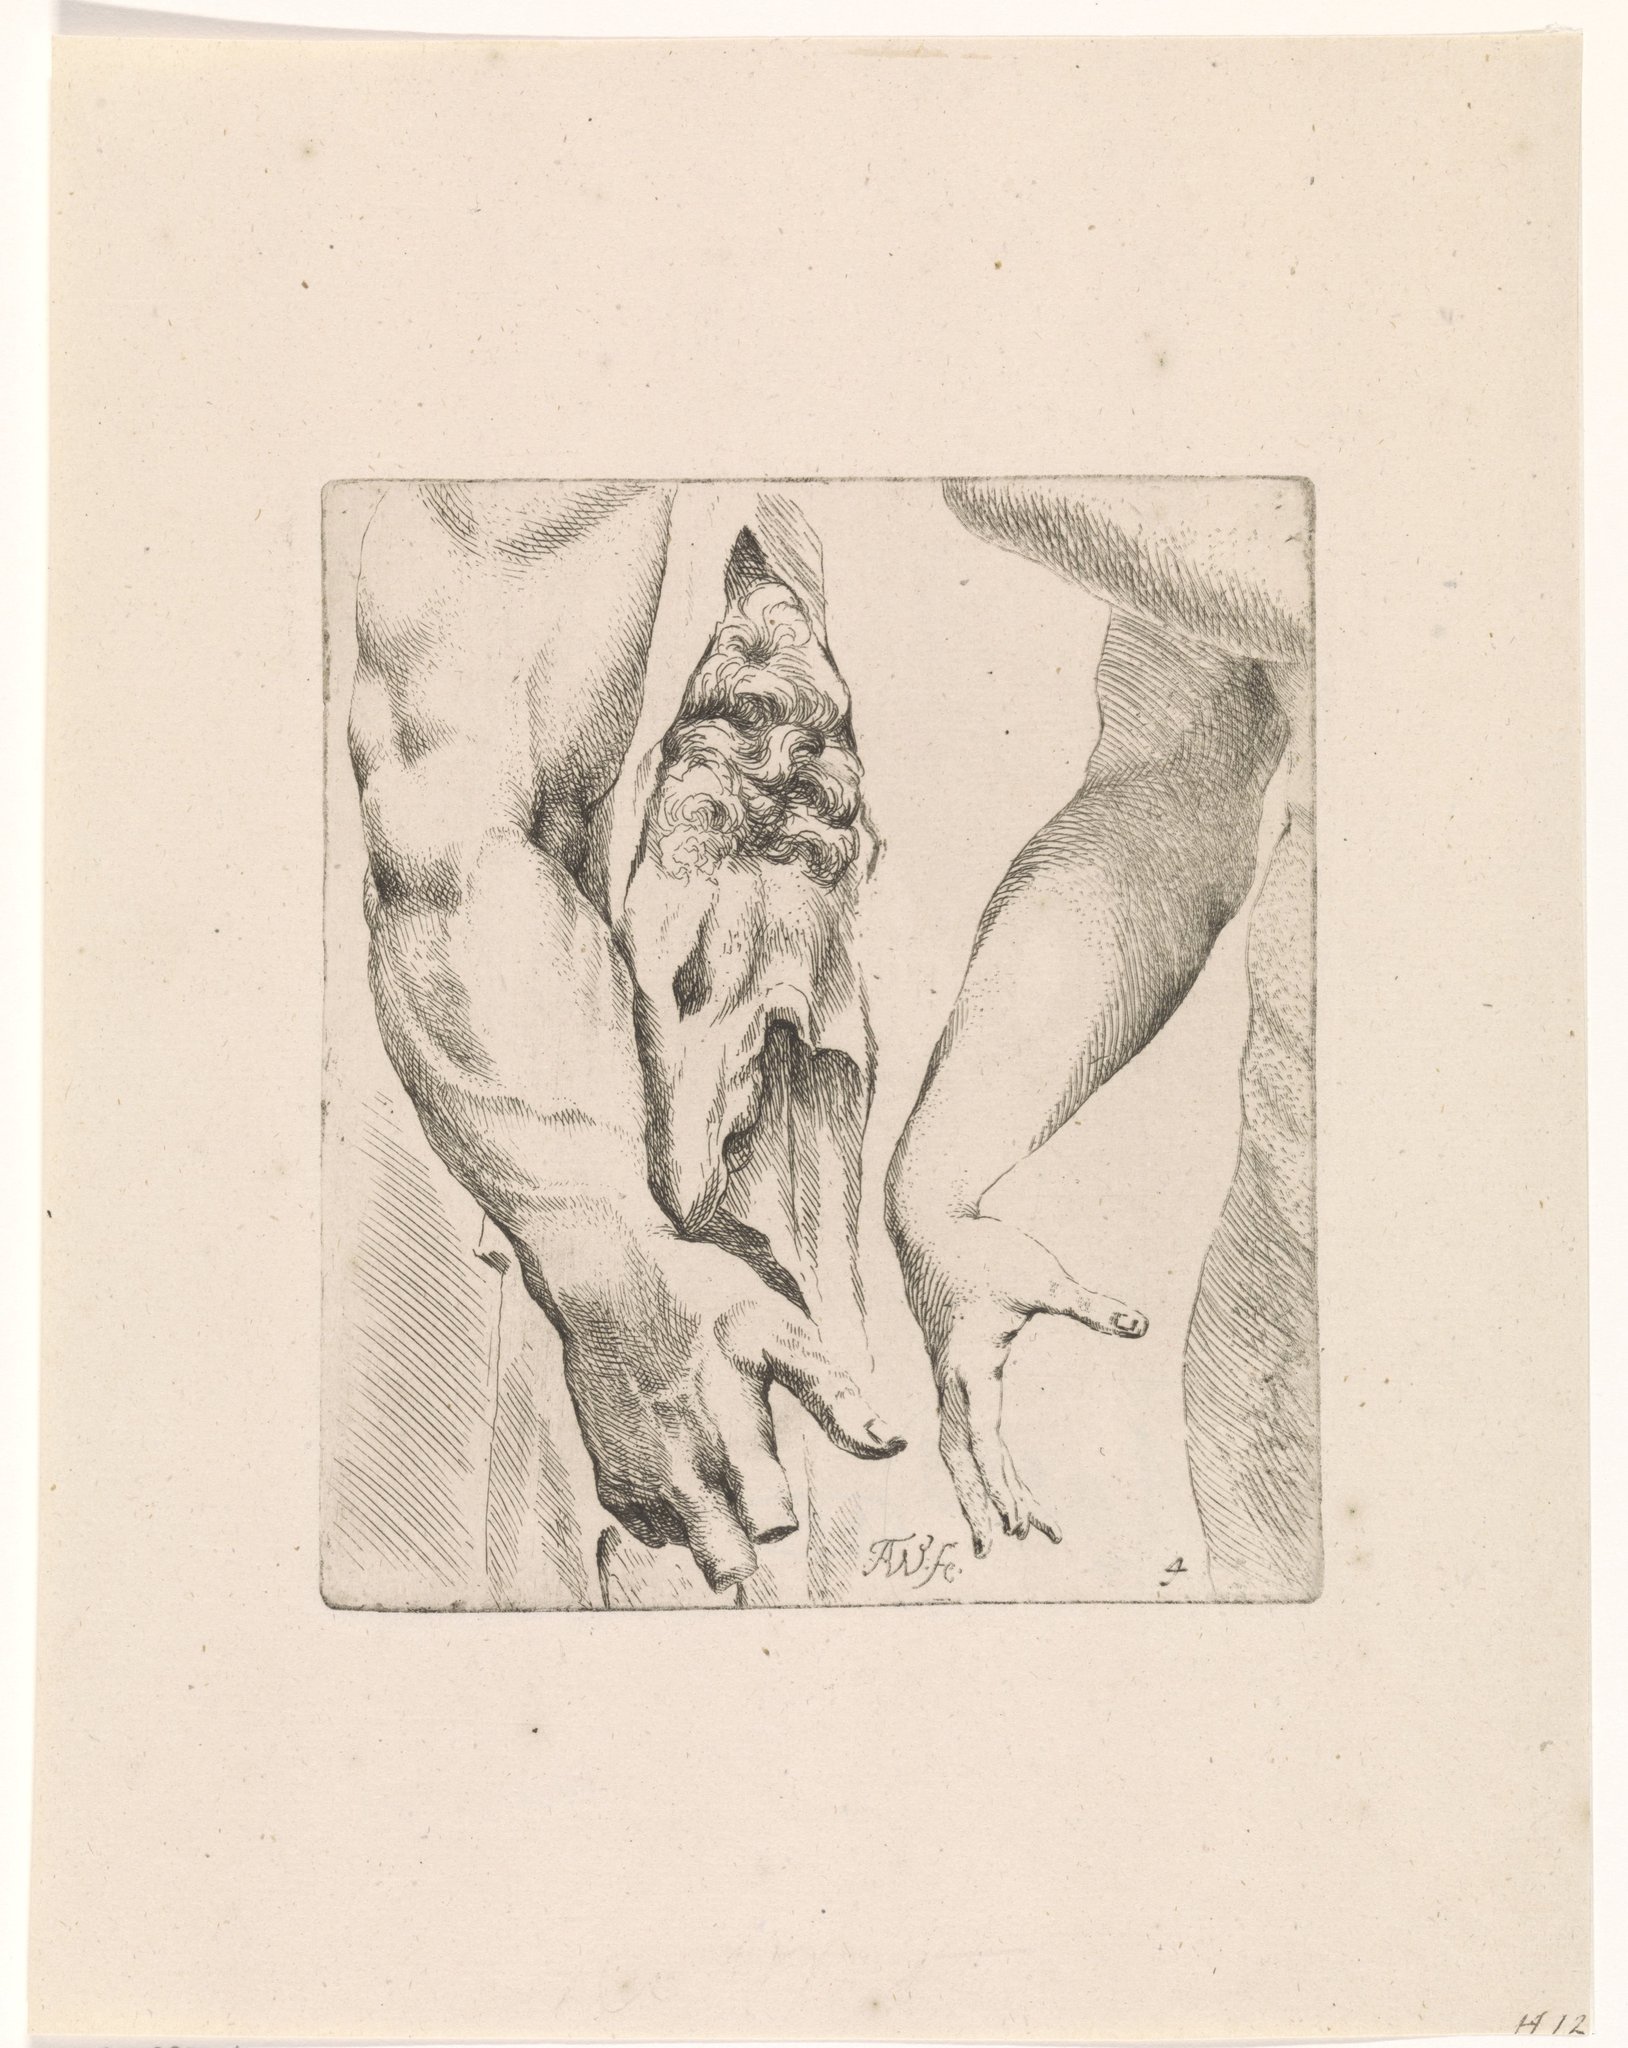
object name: print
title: Armstudies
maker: augustinus terwesten (i)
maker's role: draughtsman, painter, print maker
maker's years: 1649-1711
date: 1672-1711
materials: paper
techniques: etching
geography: rome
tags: arms, piece of sculpture, reproduction of a piece of sculpture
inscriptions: collector's mark: Lugt 2228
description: Twee studies van armen: links van een man, rechts van een vrouw. De linkerarm naar de Hercules Farnese sculptuur.